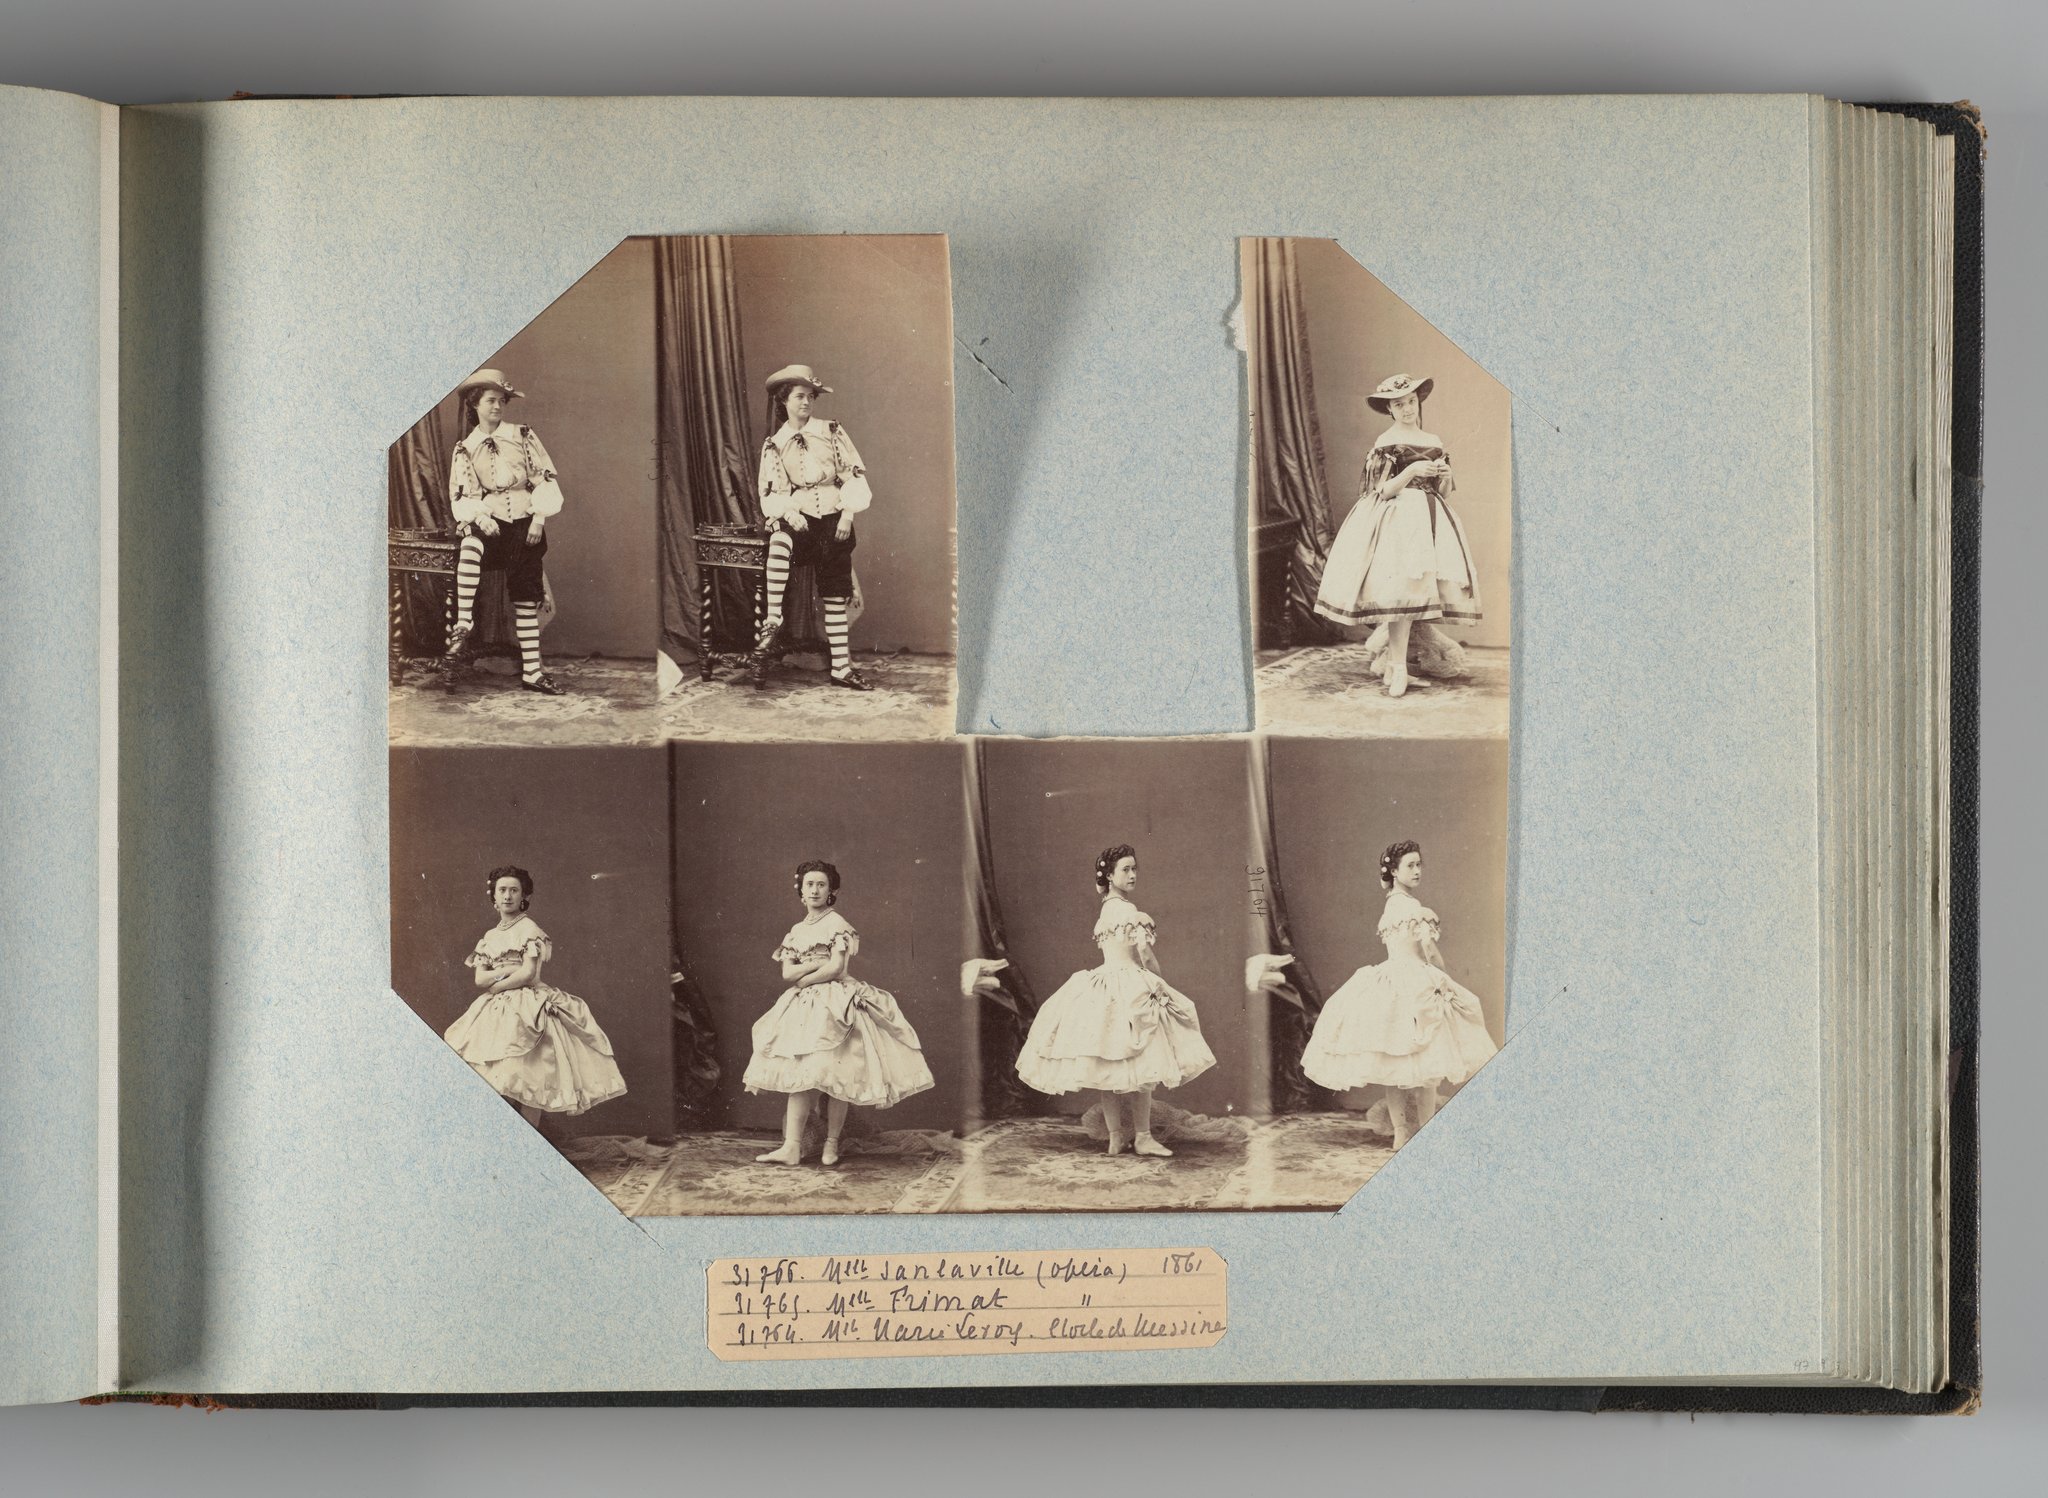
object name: photograph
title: Mlle Sanlaville; Mlle Frimat; Mlle Marie Leroy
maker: andré-adolphe-eugène disdéri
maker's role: artist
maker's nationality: french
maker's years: 1819-1889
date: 1861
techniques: albumen silver print, glass negative